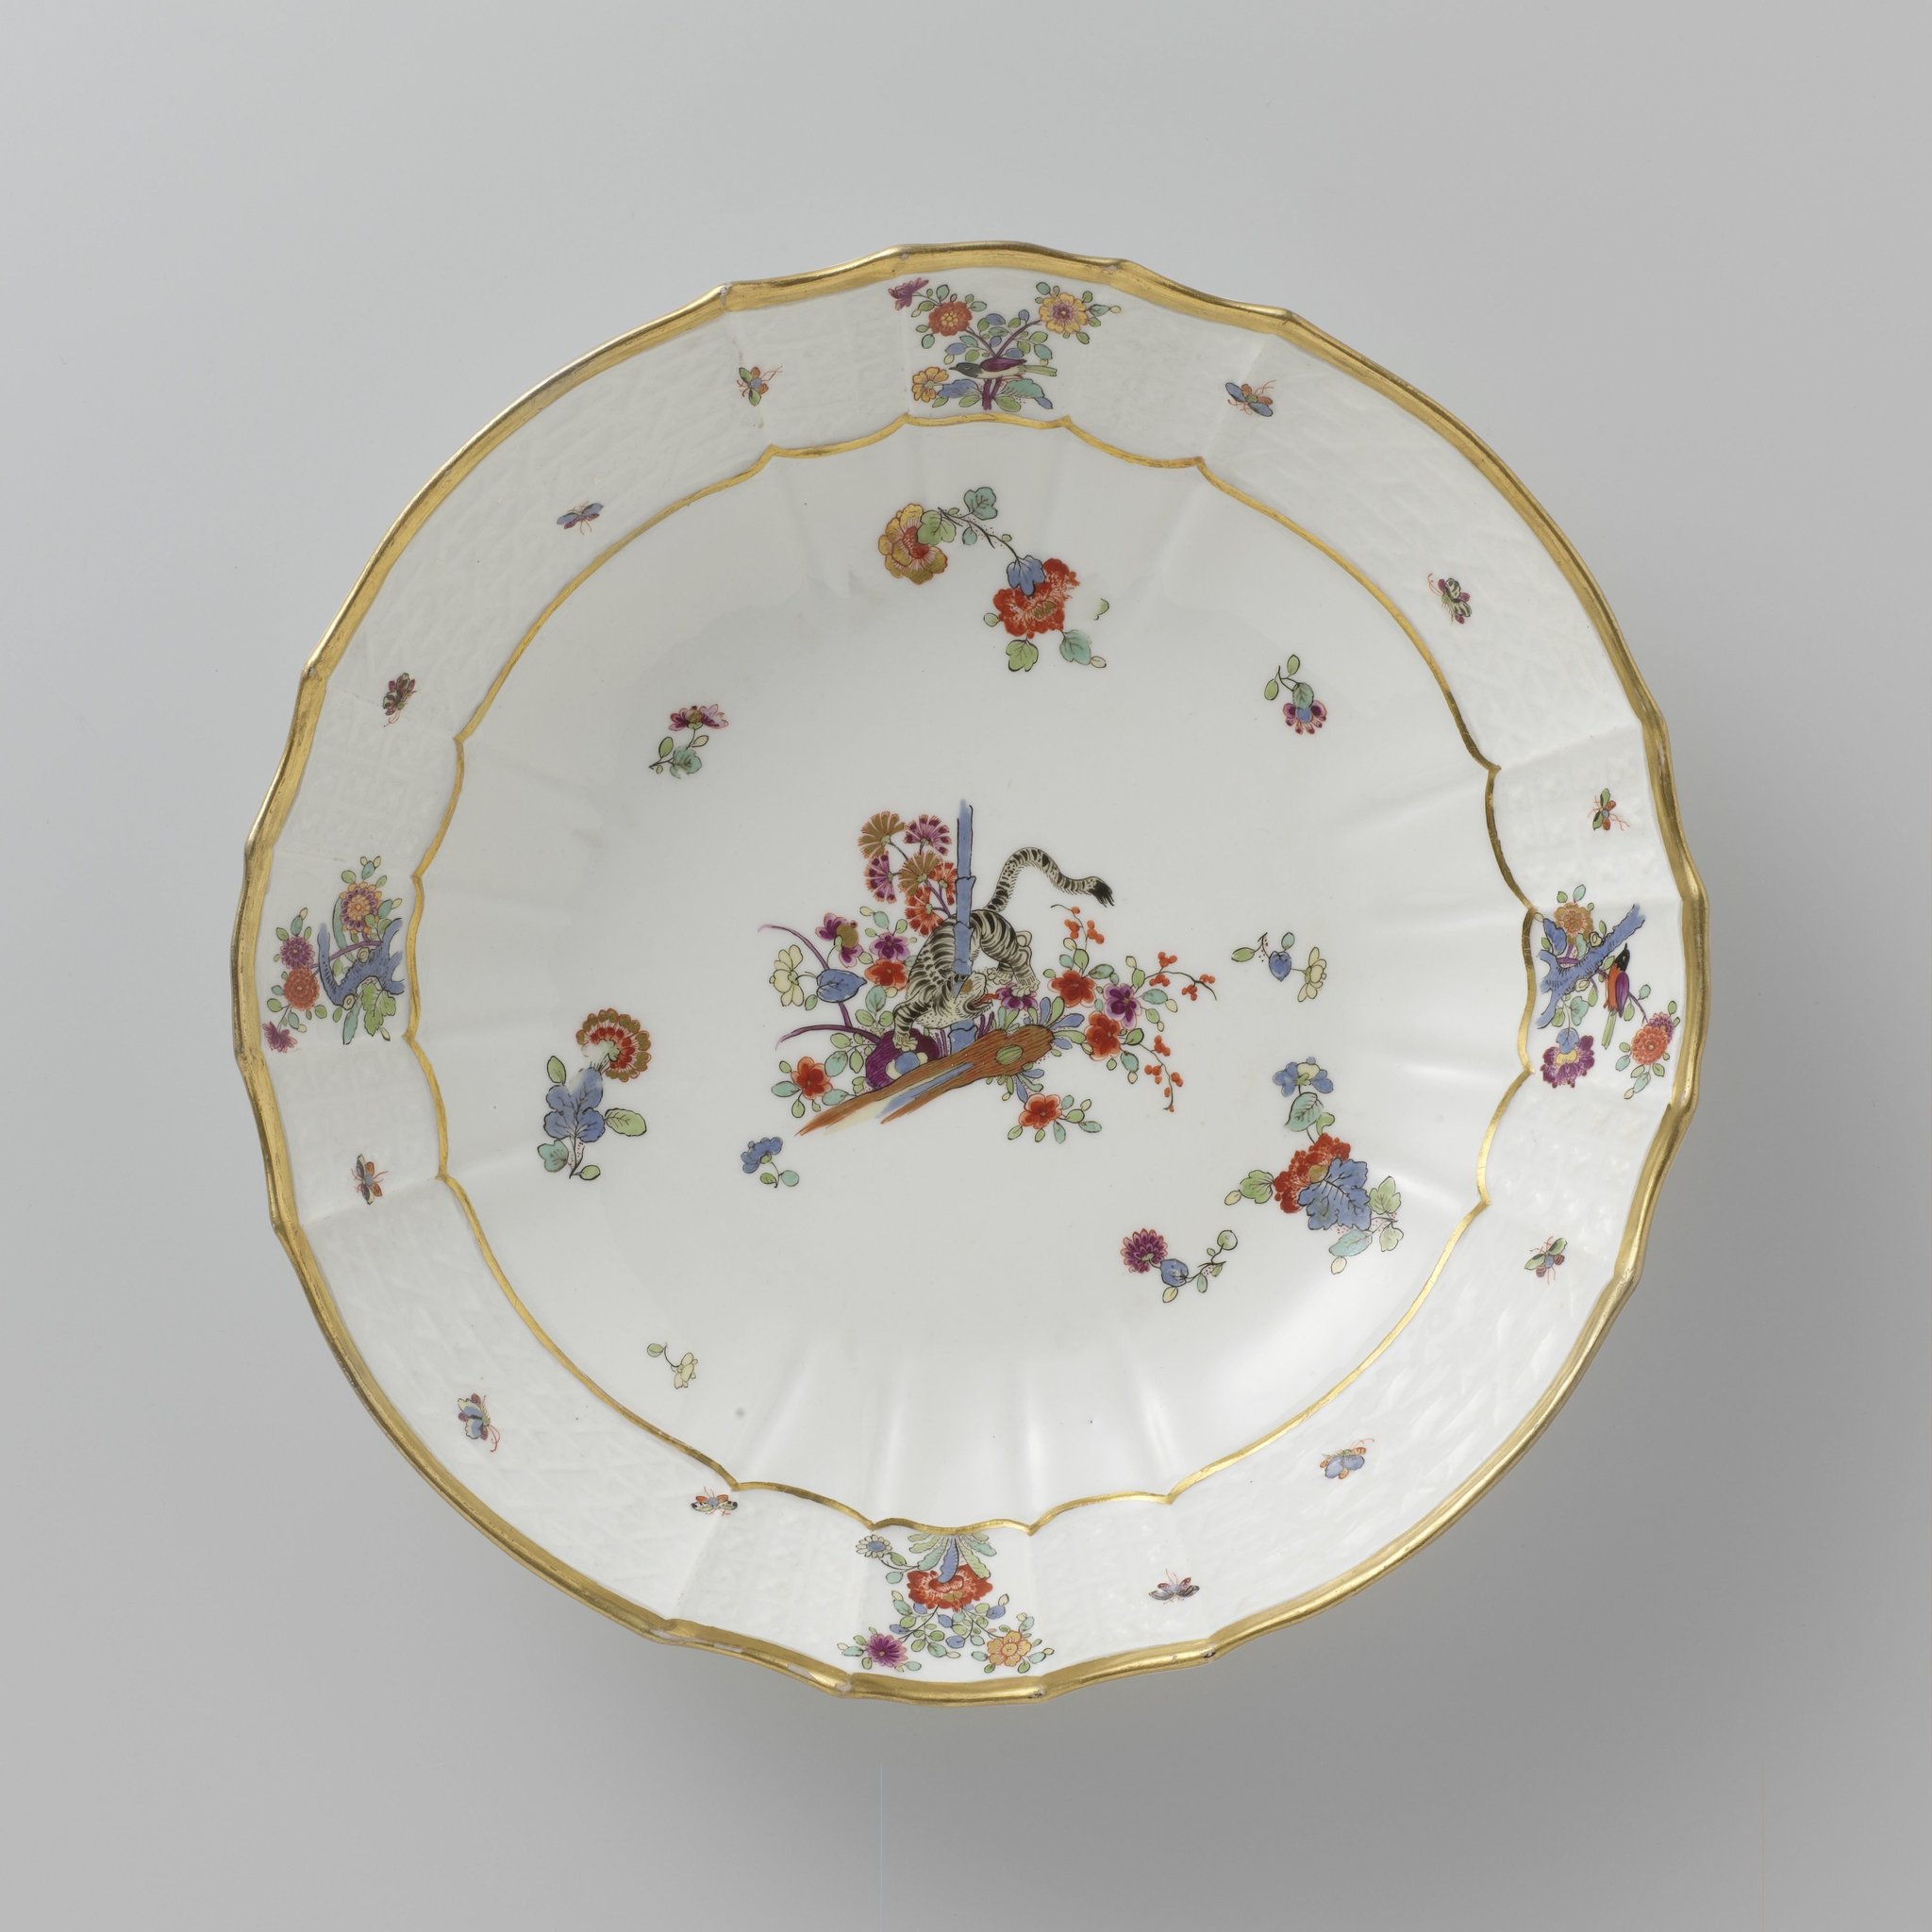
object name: eating drinking utensil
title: Schotel, veelkleurig beschilderd met een Kakiemon-decor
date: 1740-1745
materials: porcelain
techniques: painted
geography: meissen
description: Ronde schotel van beschilderd porselein. De schotel heeft een geribde en geschulpte rand. De schotel is beschilderd met een tijger om een bamboestengel, gestrooide Indianische Blumen, vlinders en takken met vogels. De rand is versierd met het 'Altbrandenstein'-patroon. De schotel is gemerkt.